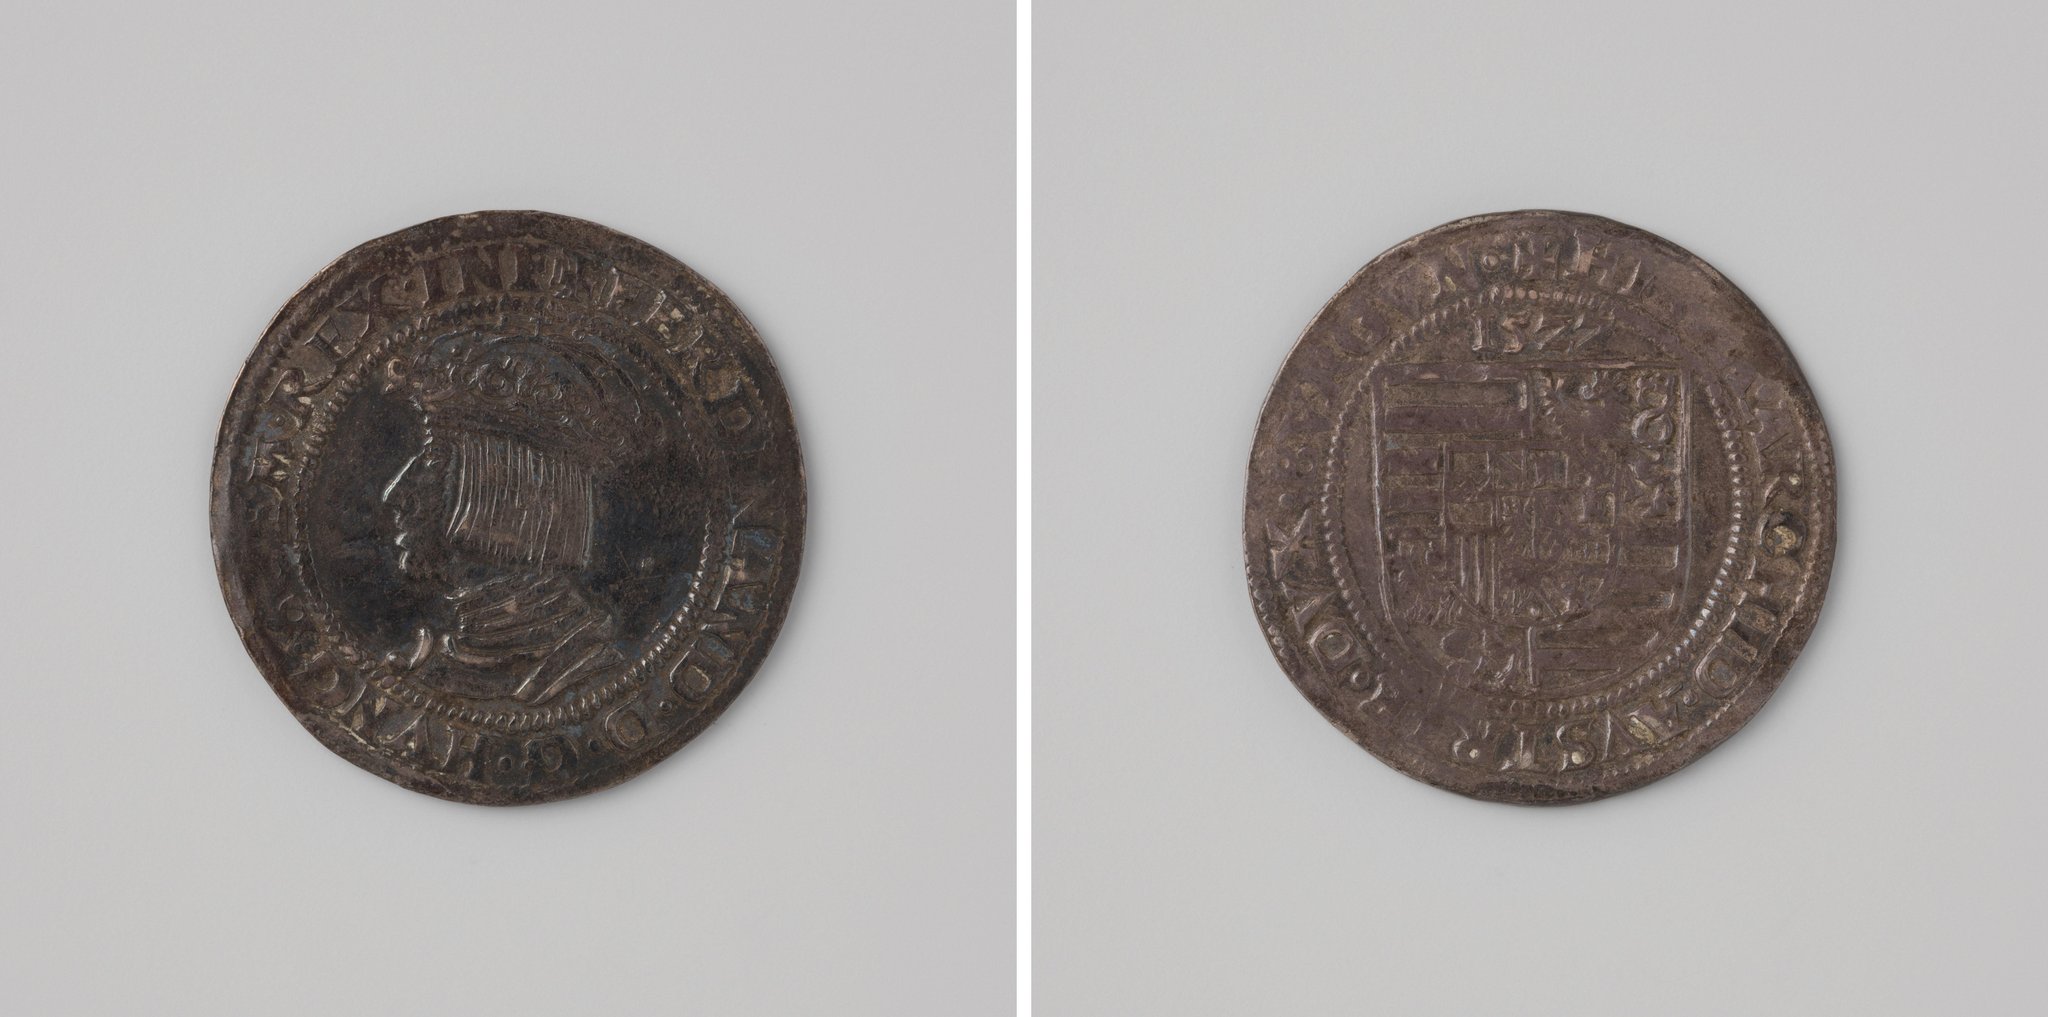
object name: coin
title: Hongarije, koning Ferdinand I, teston,1527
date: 1527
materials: silver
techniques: striking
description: Zilveren munt. Voorzijde: gekroond borstbeeld van de koning naar links. Keerzijde: samengesteld wapenschild, waarboven jaartal.